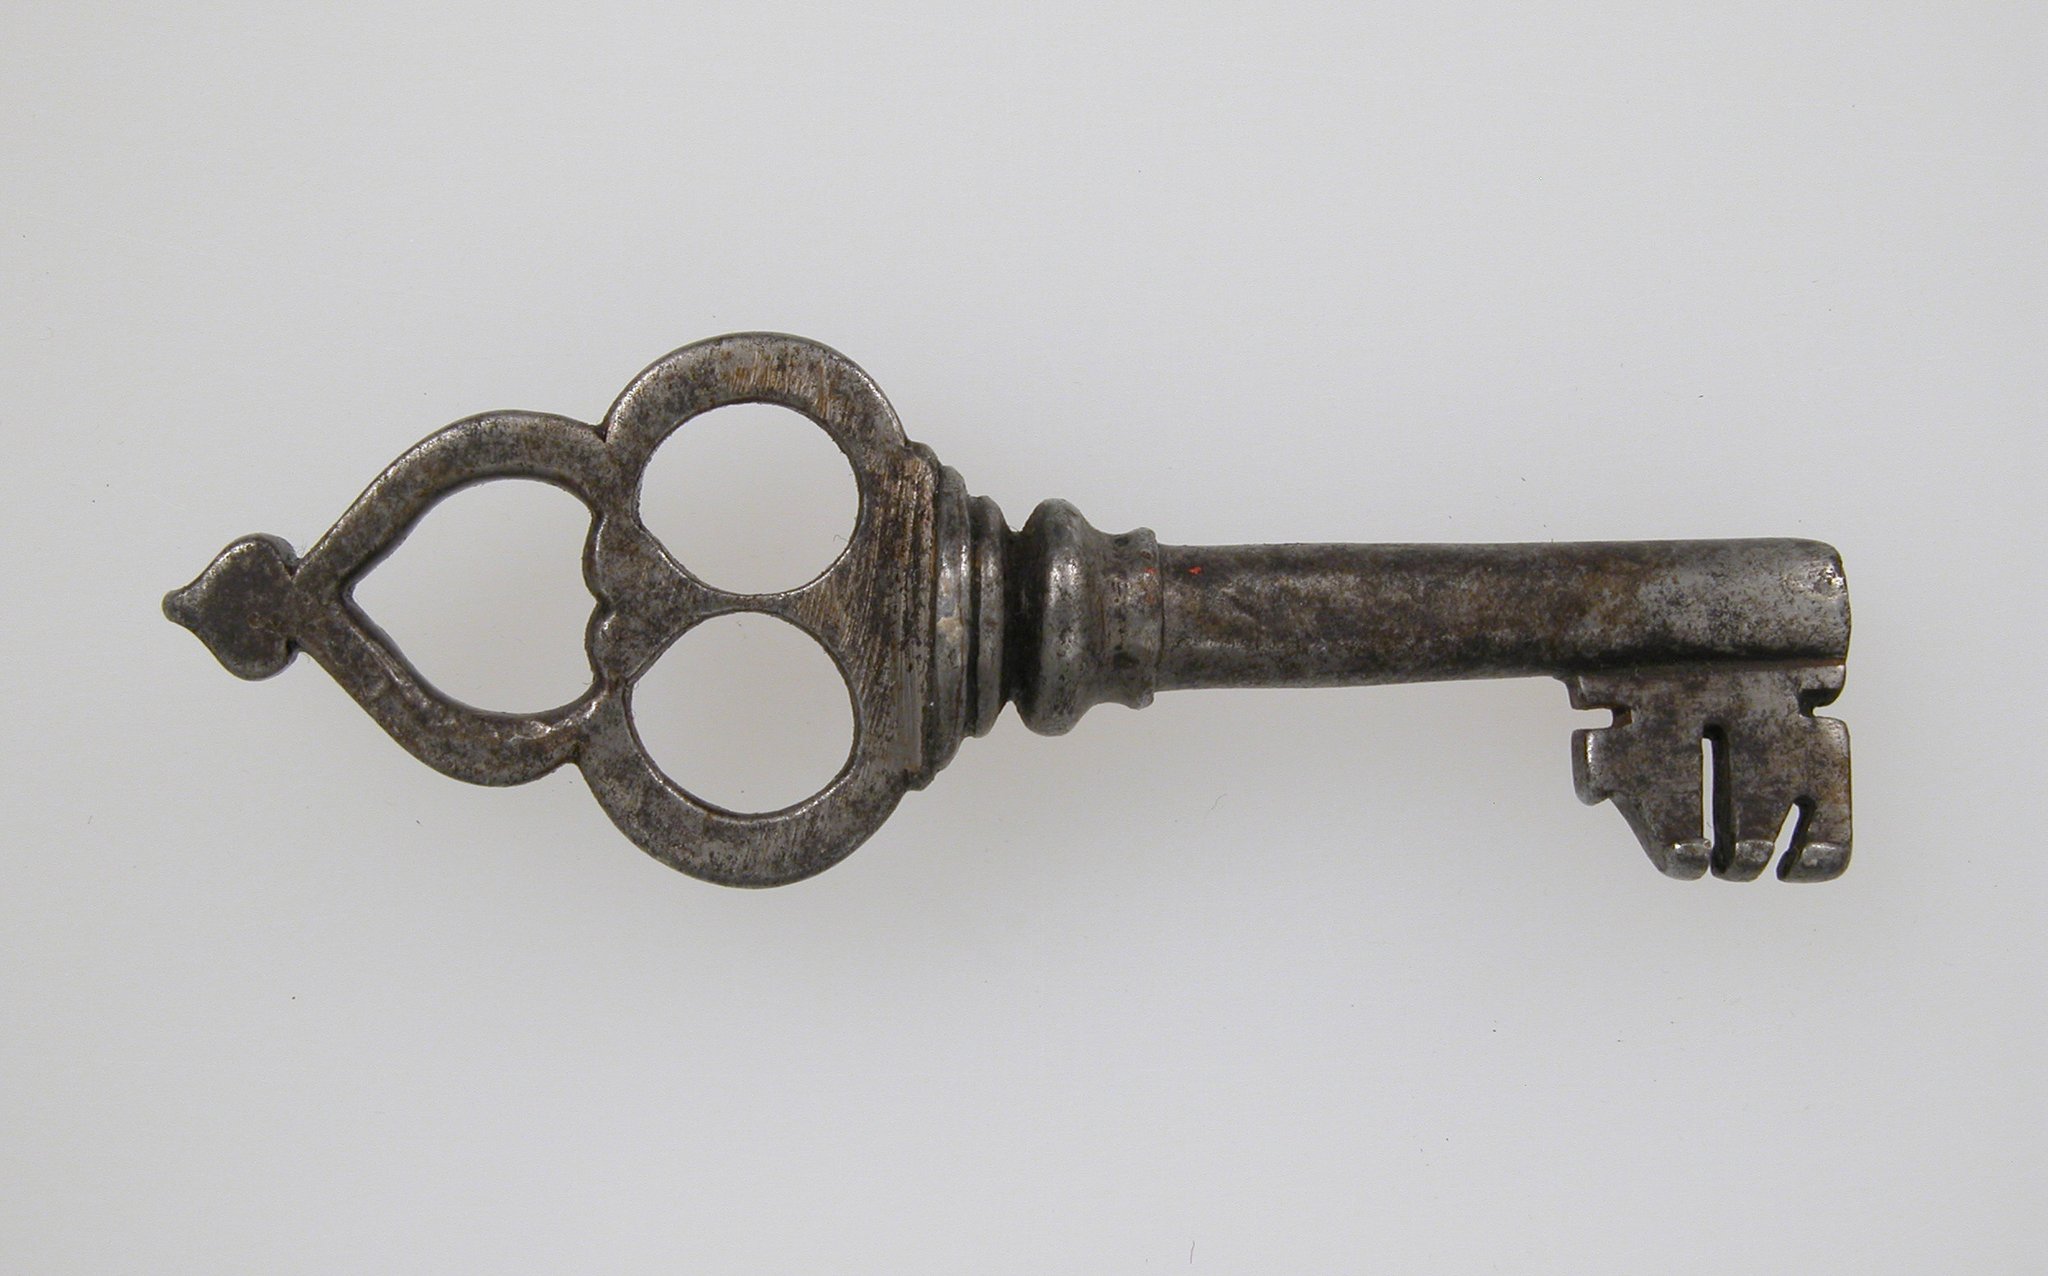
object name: key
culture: german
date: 1401-1500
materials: iron